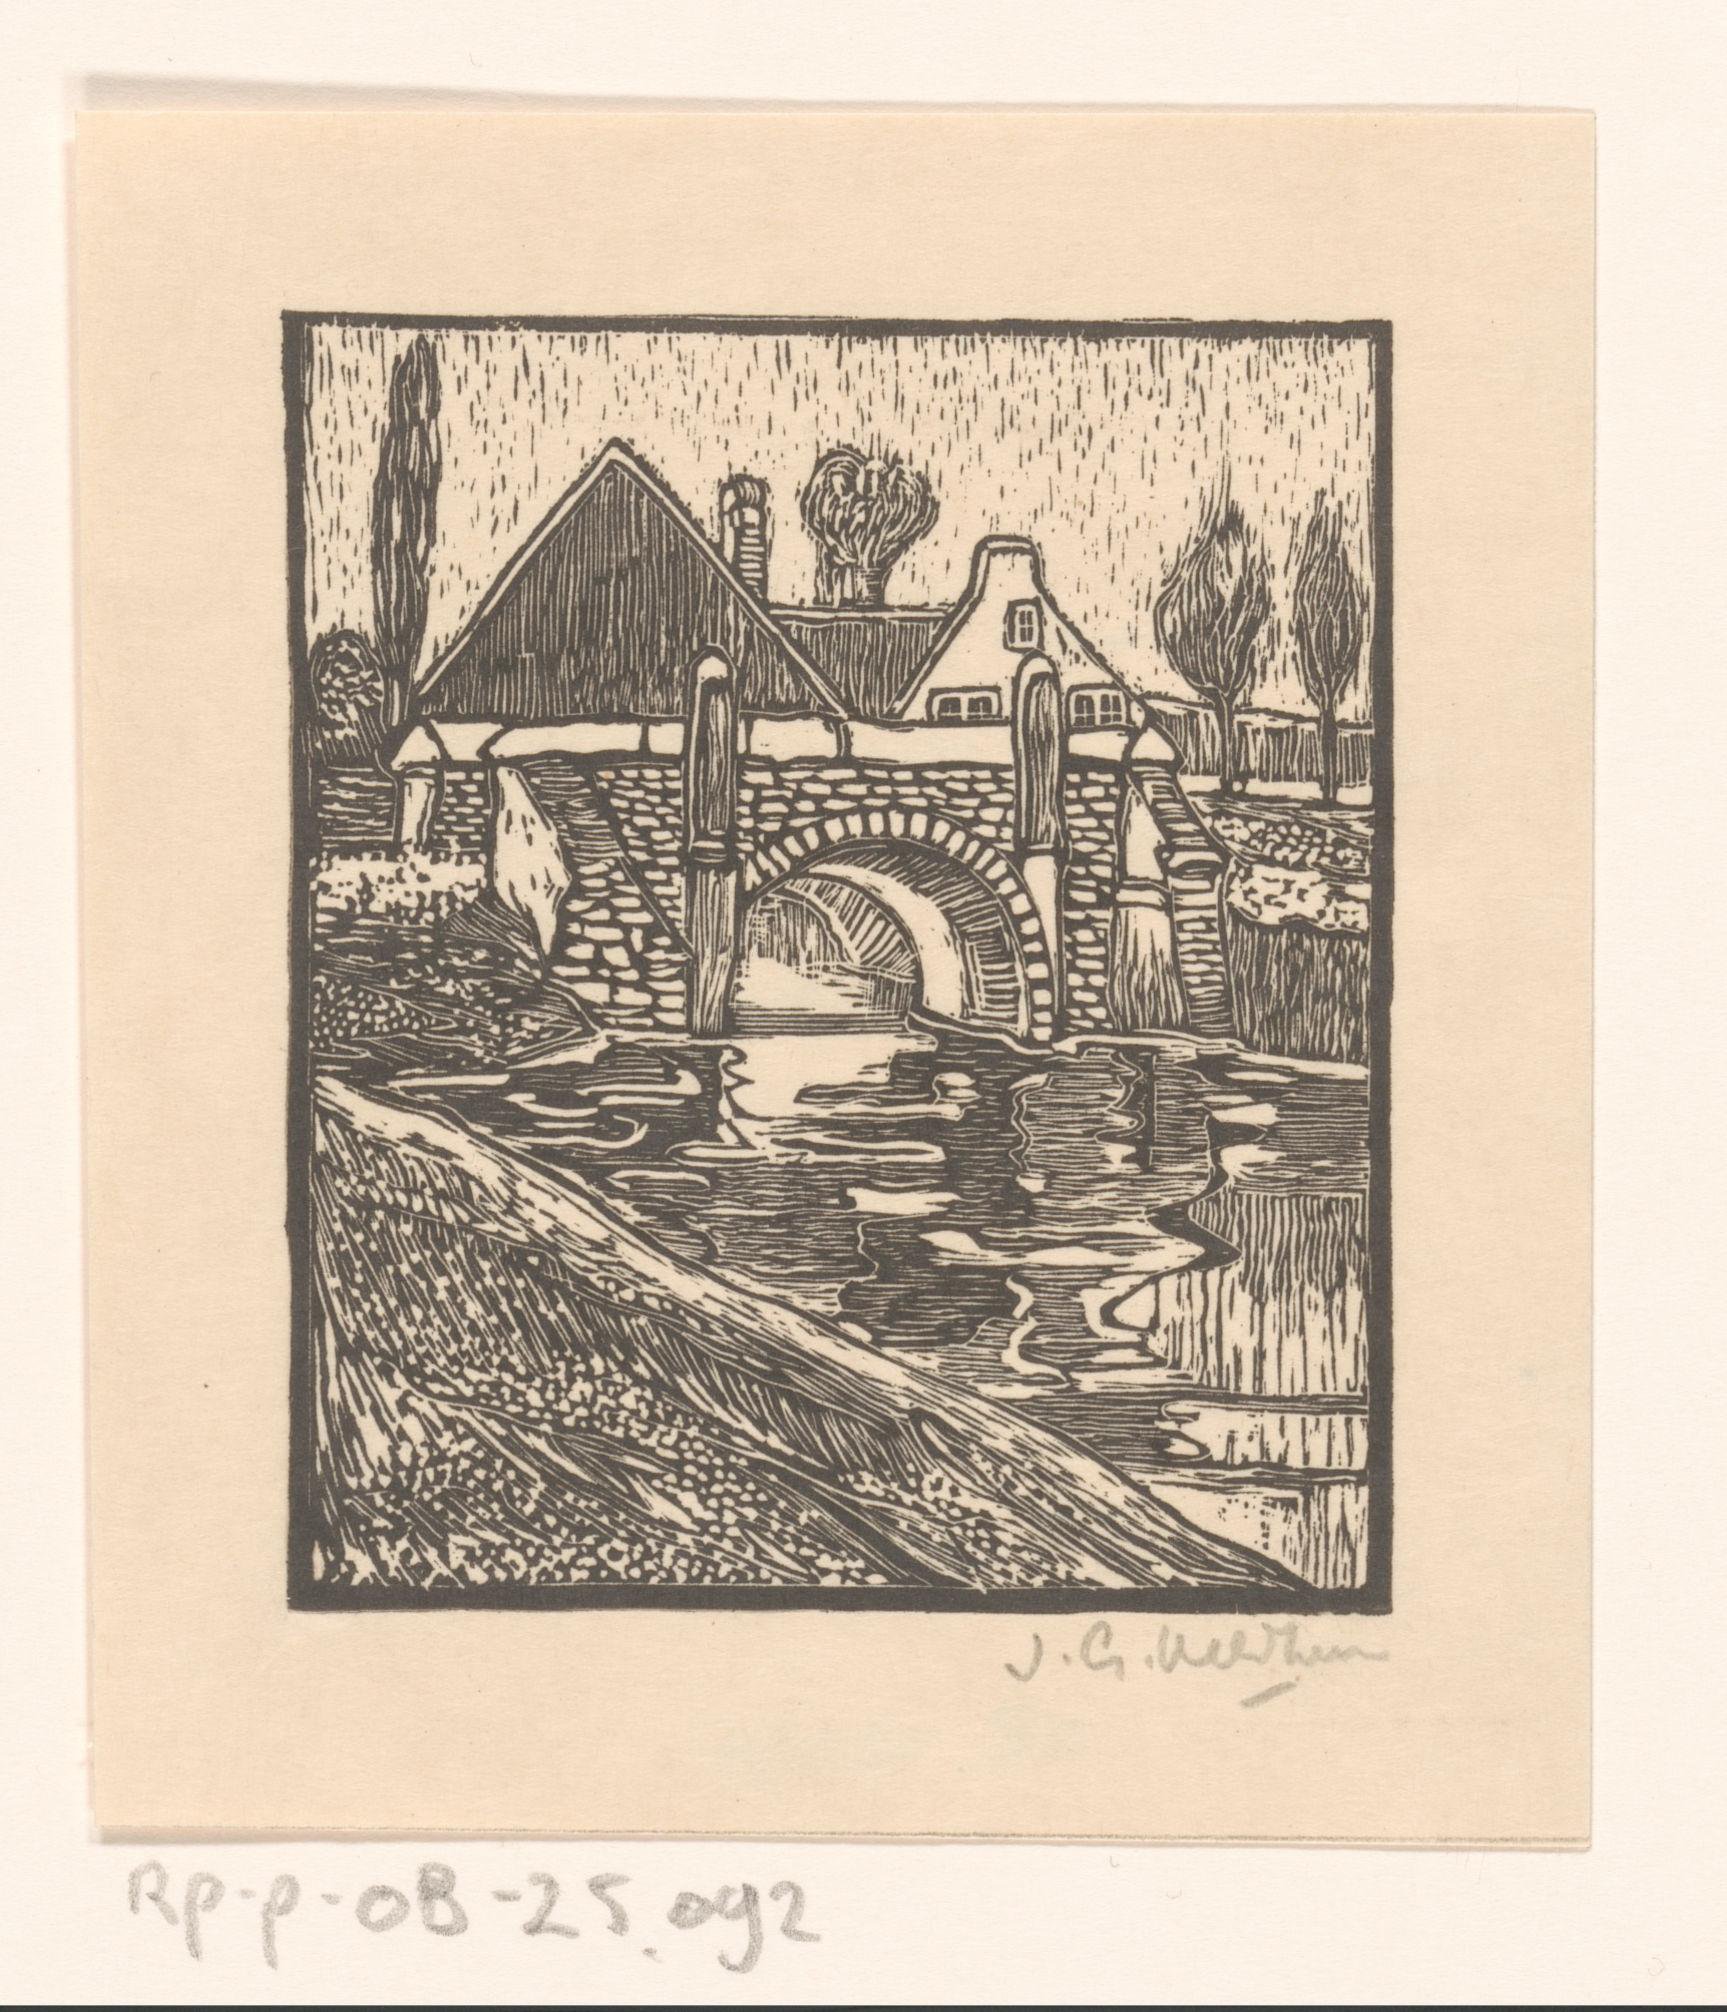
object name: print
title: Brug over een vaart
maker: jacobus gerardus veldheer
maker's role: draughtsman, print maker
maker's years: 1866-1954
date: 1876-1954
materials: paper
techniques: woodcut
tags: canal, bridge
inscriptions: annotation: ‘[...] brug over een der vijvers v.h. khof te [...]’, collector's mark: Lugt 2228